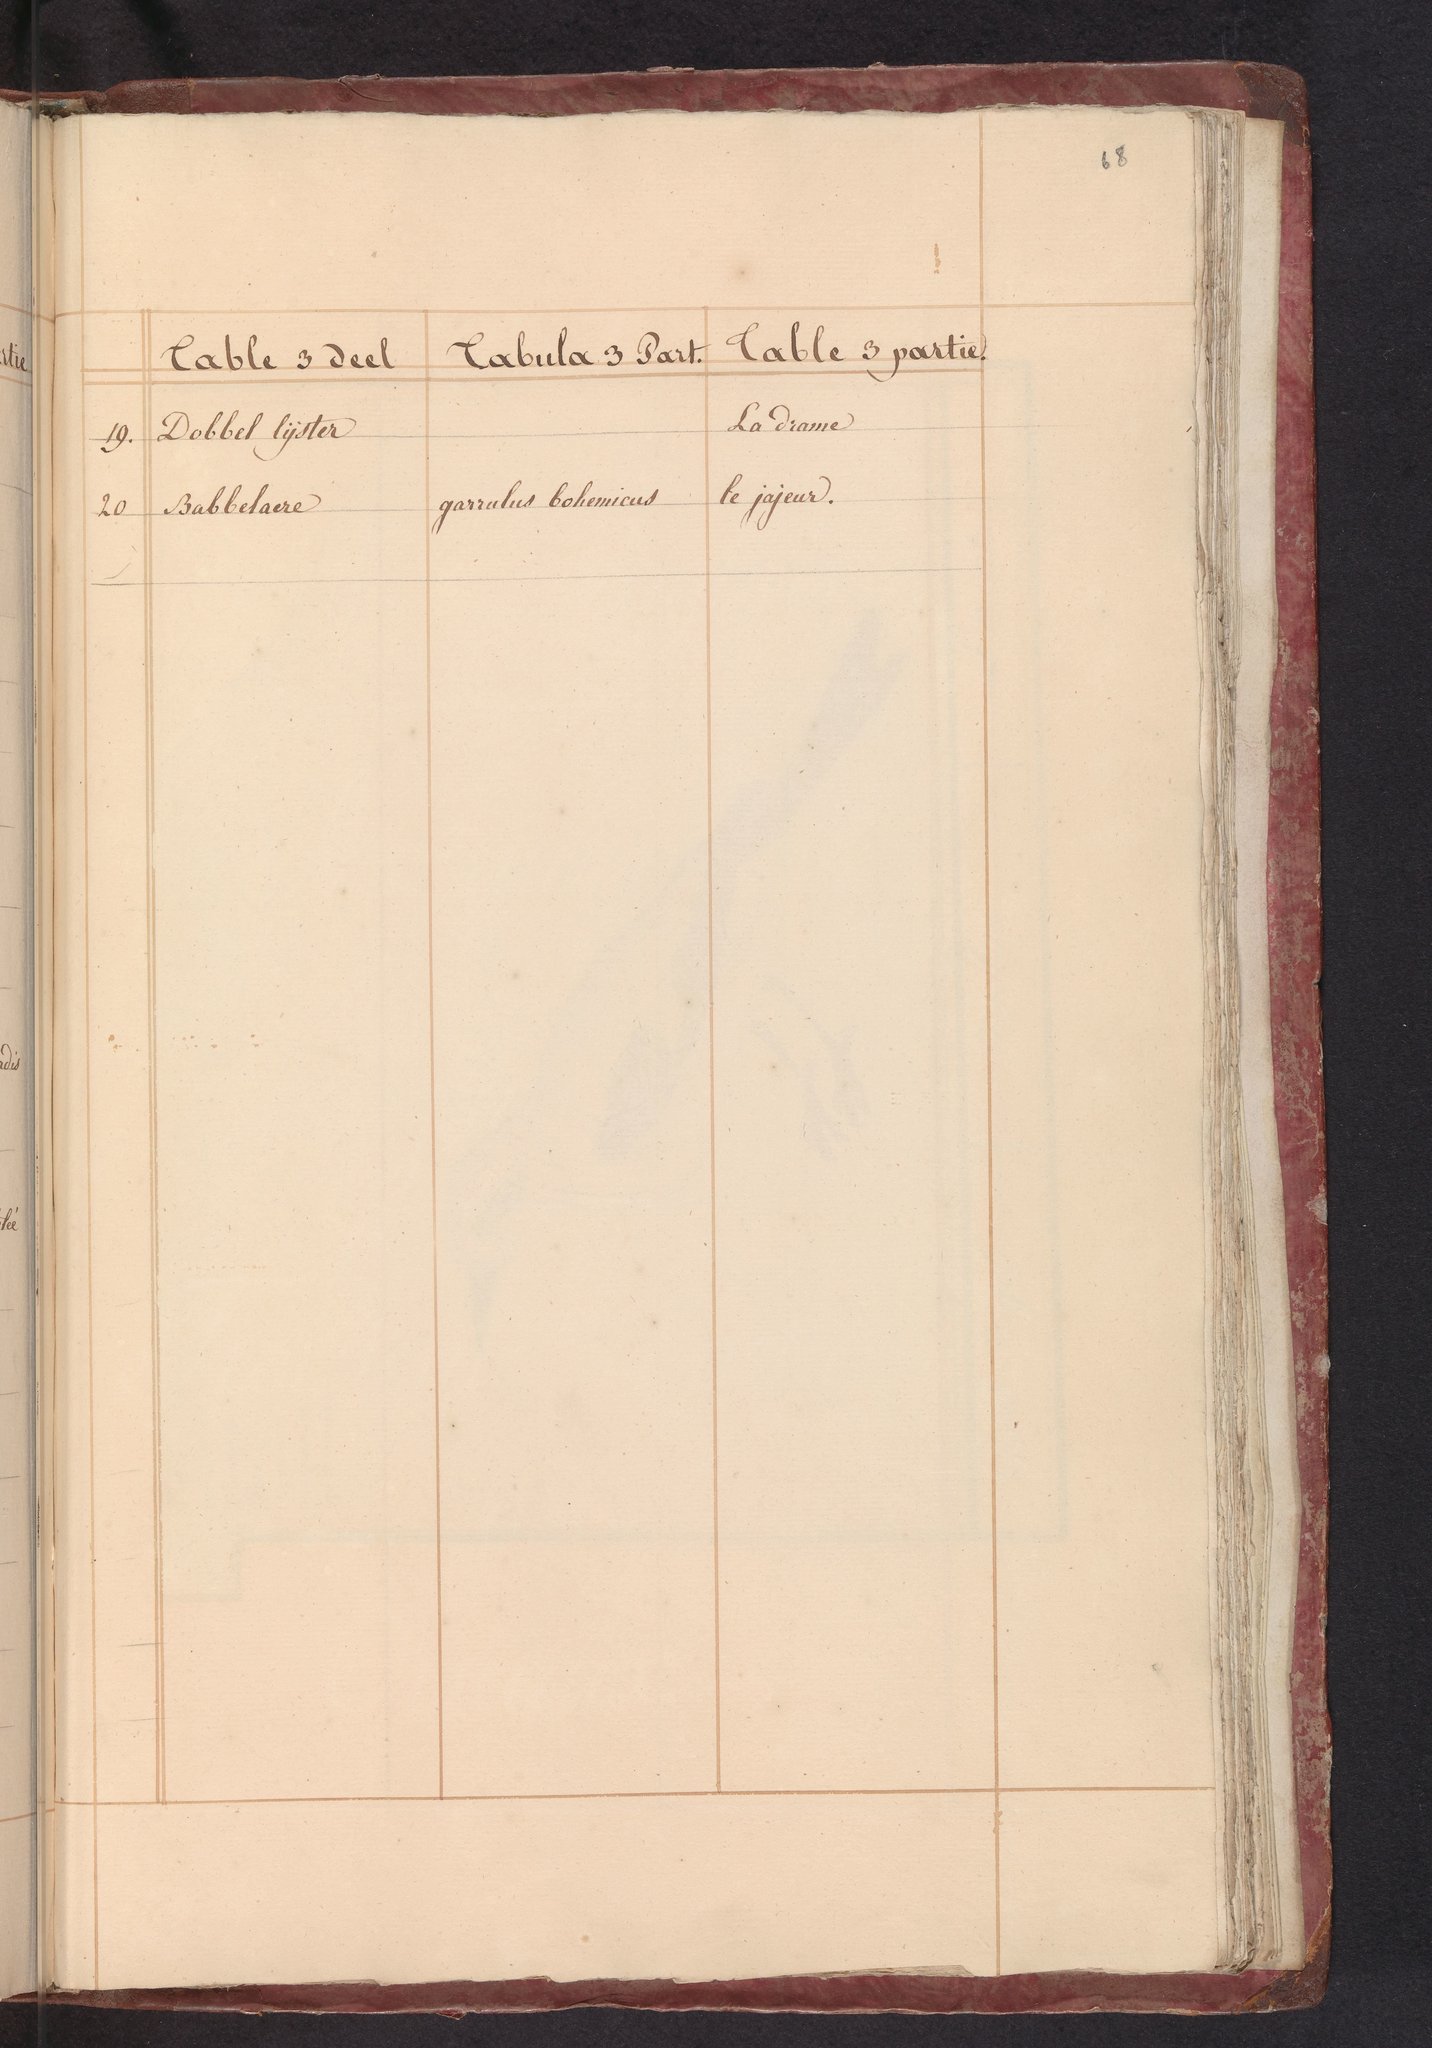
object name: manuscript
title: Table 3 deel / Tabula 3 Part. / Table 3 partie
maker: joseph van huerne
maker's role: kunstliefhebber, mecenas, verzamelaar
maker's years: 1752-1844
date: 1809-1814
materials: ink, paper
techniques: handwriting, pen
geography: bruges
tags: handwriting, written text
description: Schema met een lijst van vogels voorgesteld in het derde deel van de vogels: nummers 19-20. Onderdeel van het eerste album met tekeningen van vogels. Derde van twaalf albums met tekeningen van dieren, vogels en planten bekend rond 1600, gemaakt in opdracht van keizer Rudolf II. Met toelichting in Nederlands, Latijn en Frans.